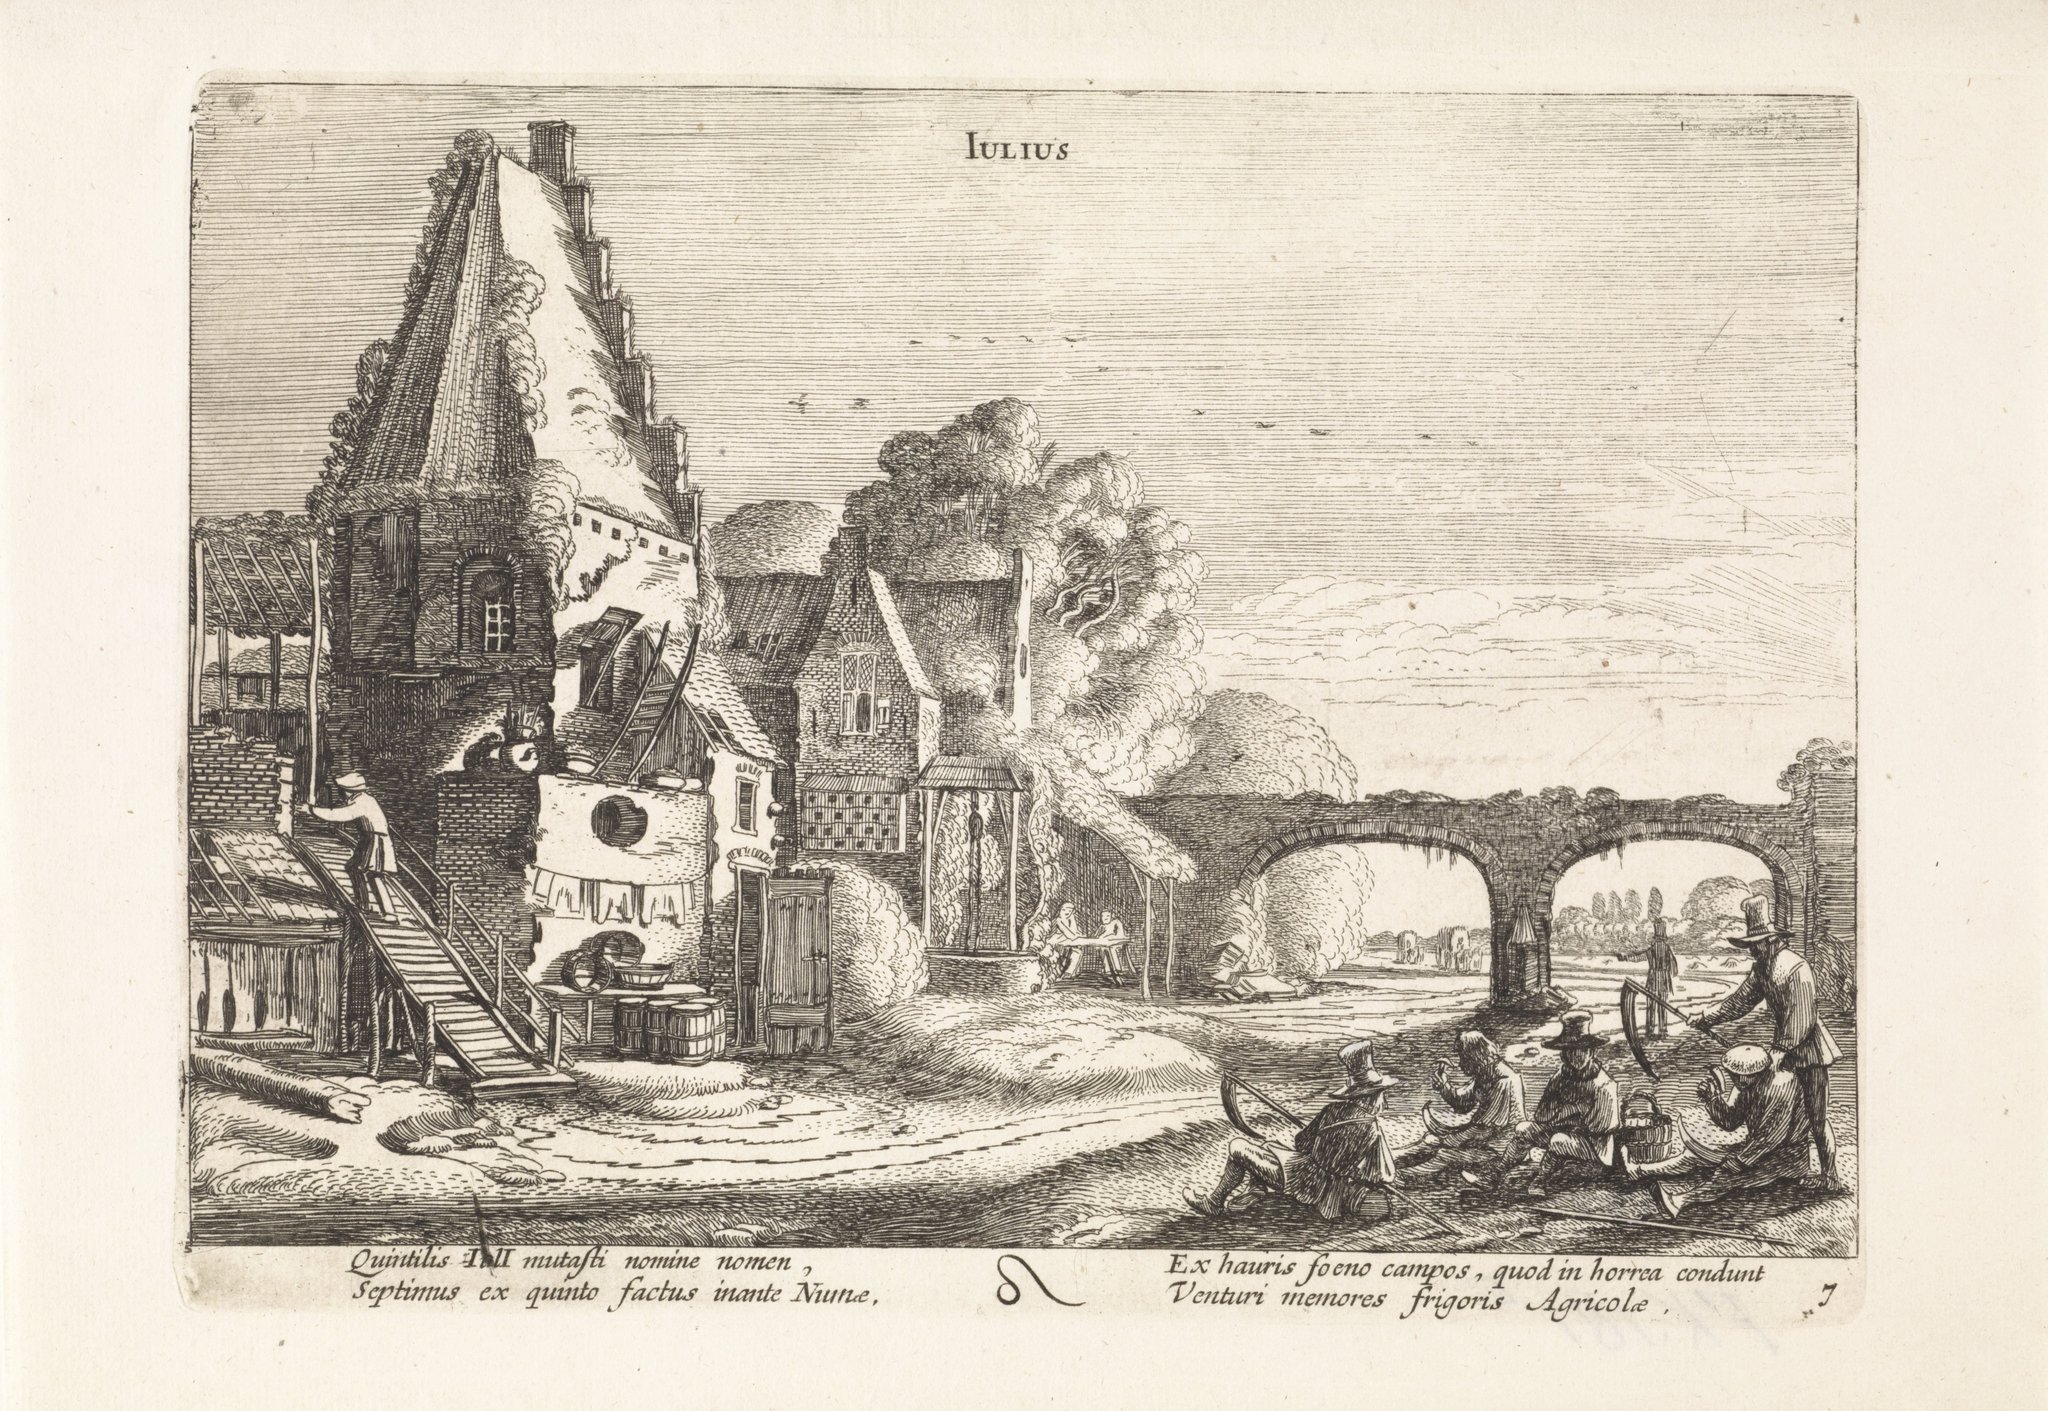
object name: print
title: De twaalf maanden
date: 1608-1618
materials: paper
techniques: etching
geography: northern netherlands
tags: agricultural implements: scythe, landscape with bridge, viaduct or aqueduct, leo (zodiacal sign of july), rest during harvest (eating, dancing, making love, etc.), tower (of house or building), landscape symbolizing july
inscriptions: collector's mark: Lugt 964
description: Gezicht op een huis en een aqauduct, waarvoor rustende maaiers met hun zeisen, voorstellende de maand juli. In het midden twee figuren aan een tafel bij een waterput. Onderaan het astrologische symbool van het sterrenbeeld leeuw. Prent uit een serie van twaalf.